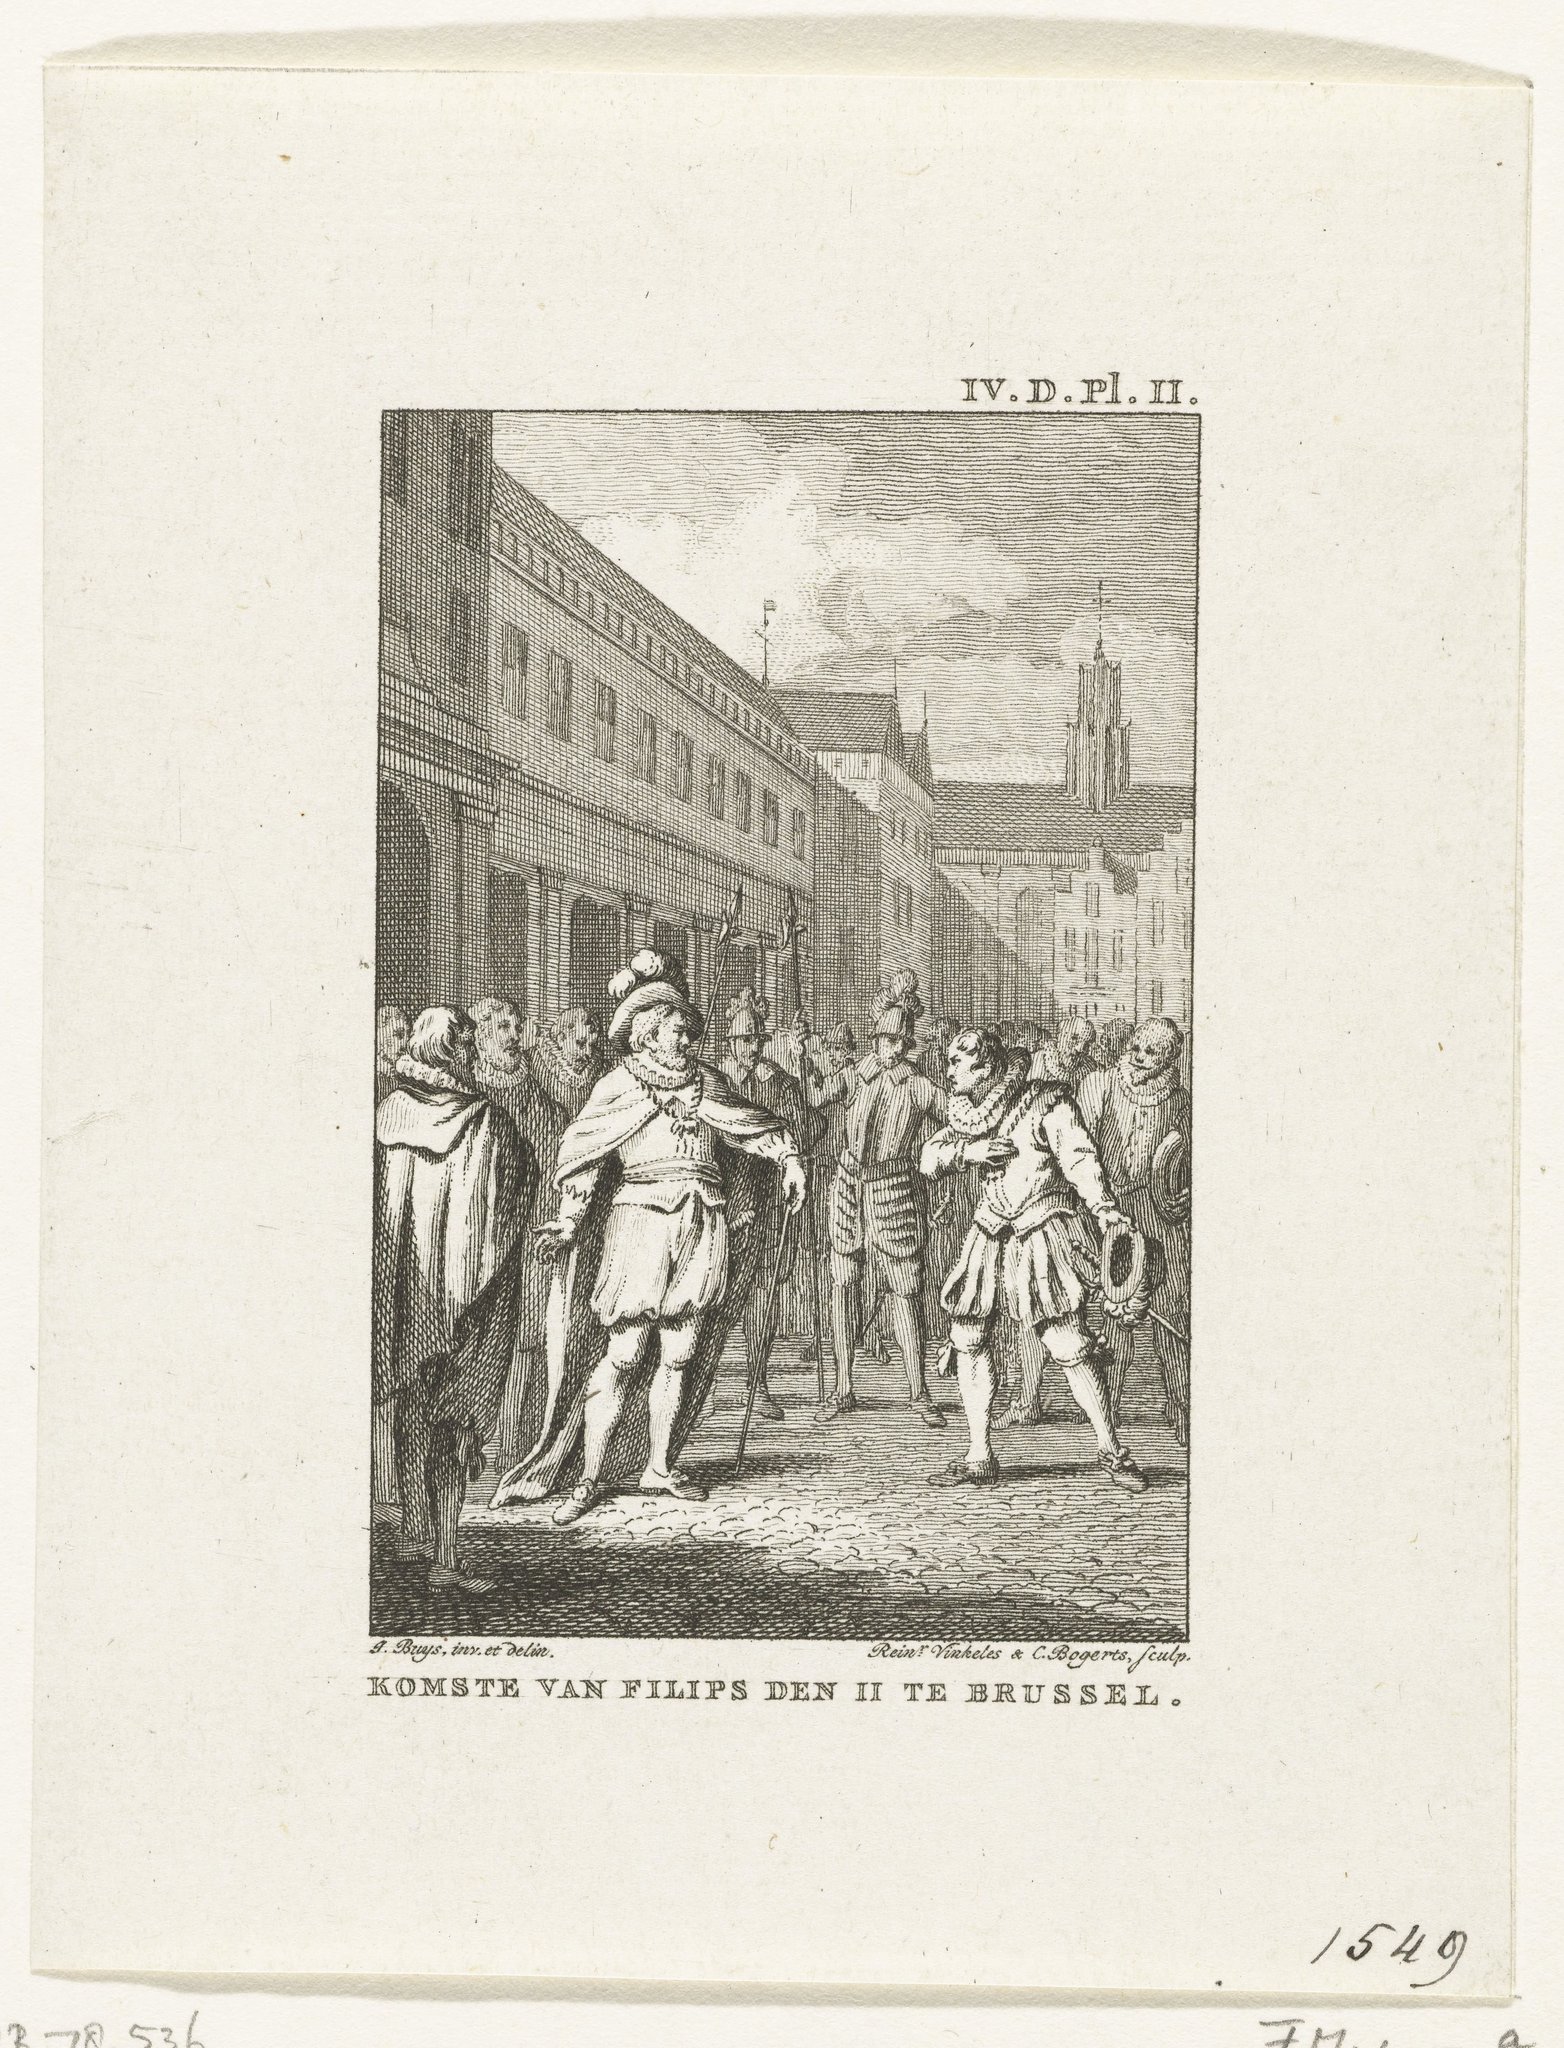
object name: print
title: Komste van Filips den II te Brussel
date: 1780-1795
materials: paper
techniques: etching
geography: netherlands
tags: philip ii of spain, ghent, charles v (holy roman emperor and king of spain)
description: Illustratie voor: J. Fokke, Geschiedenissen der Vereenigde Nederlanden voor de vaderlandsche jeugd, Johannes Allart, Amsterdam 1783-1795, 25 delen, dl. IV, pl. II. Staat met de letter.